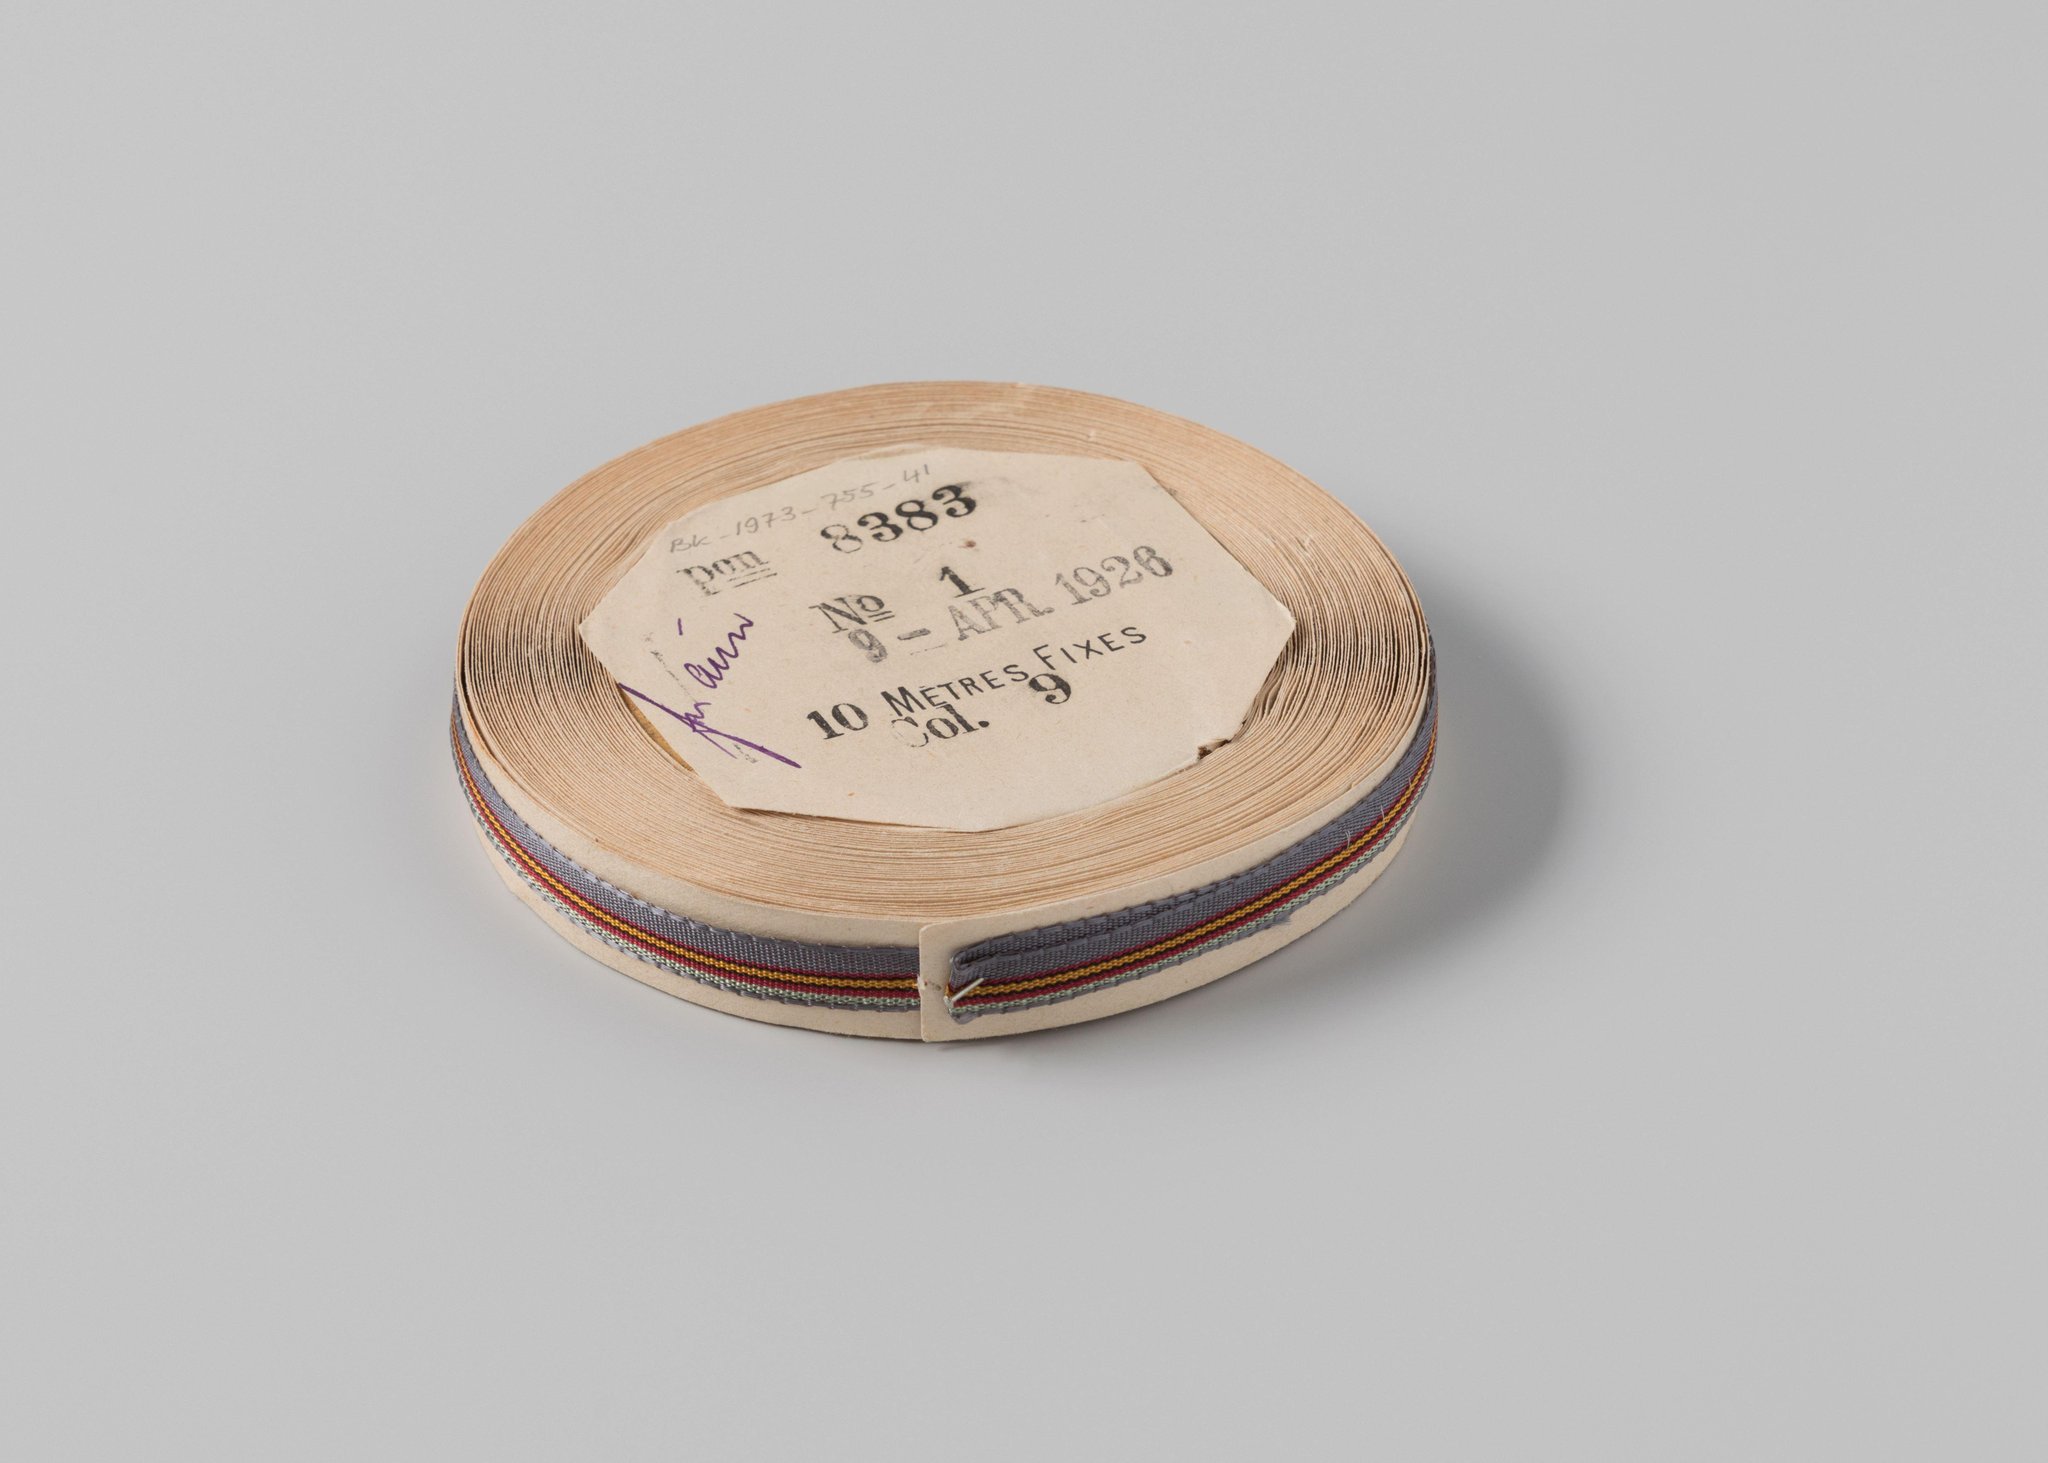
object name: braid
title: Lint op rol, gestreept, grijs met magenta, zwart, groen en oranje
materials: cardboard, paper, textile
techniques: weave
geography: france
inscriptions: number: ‘Pon 8383’, stamp: ‘9 - APR. 1926’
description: Lint op rol, gestreept, grijs met magenta, zwart, groen en oranje.